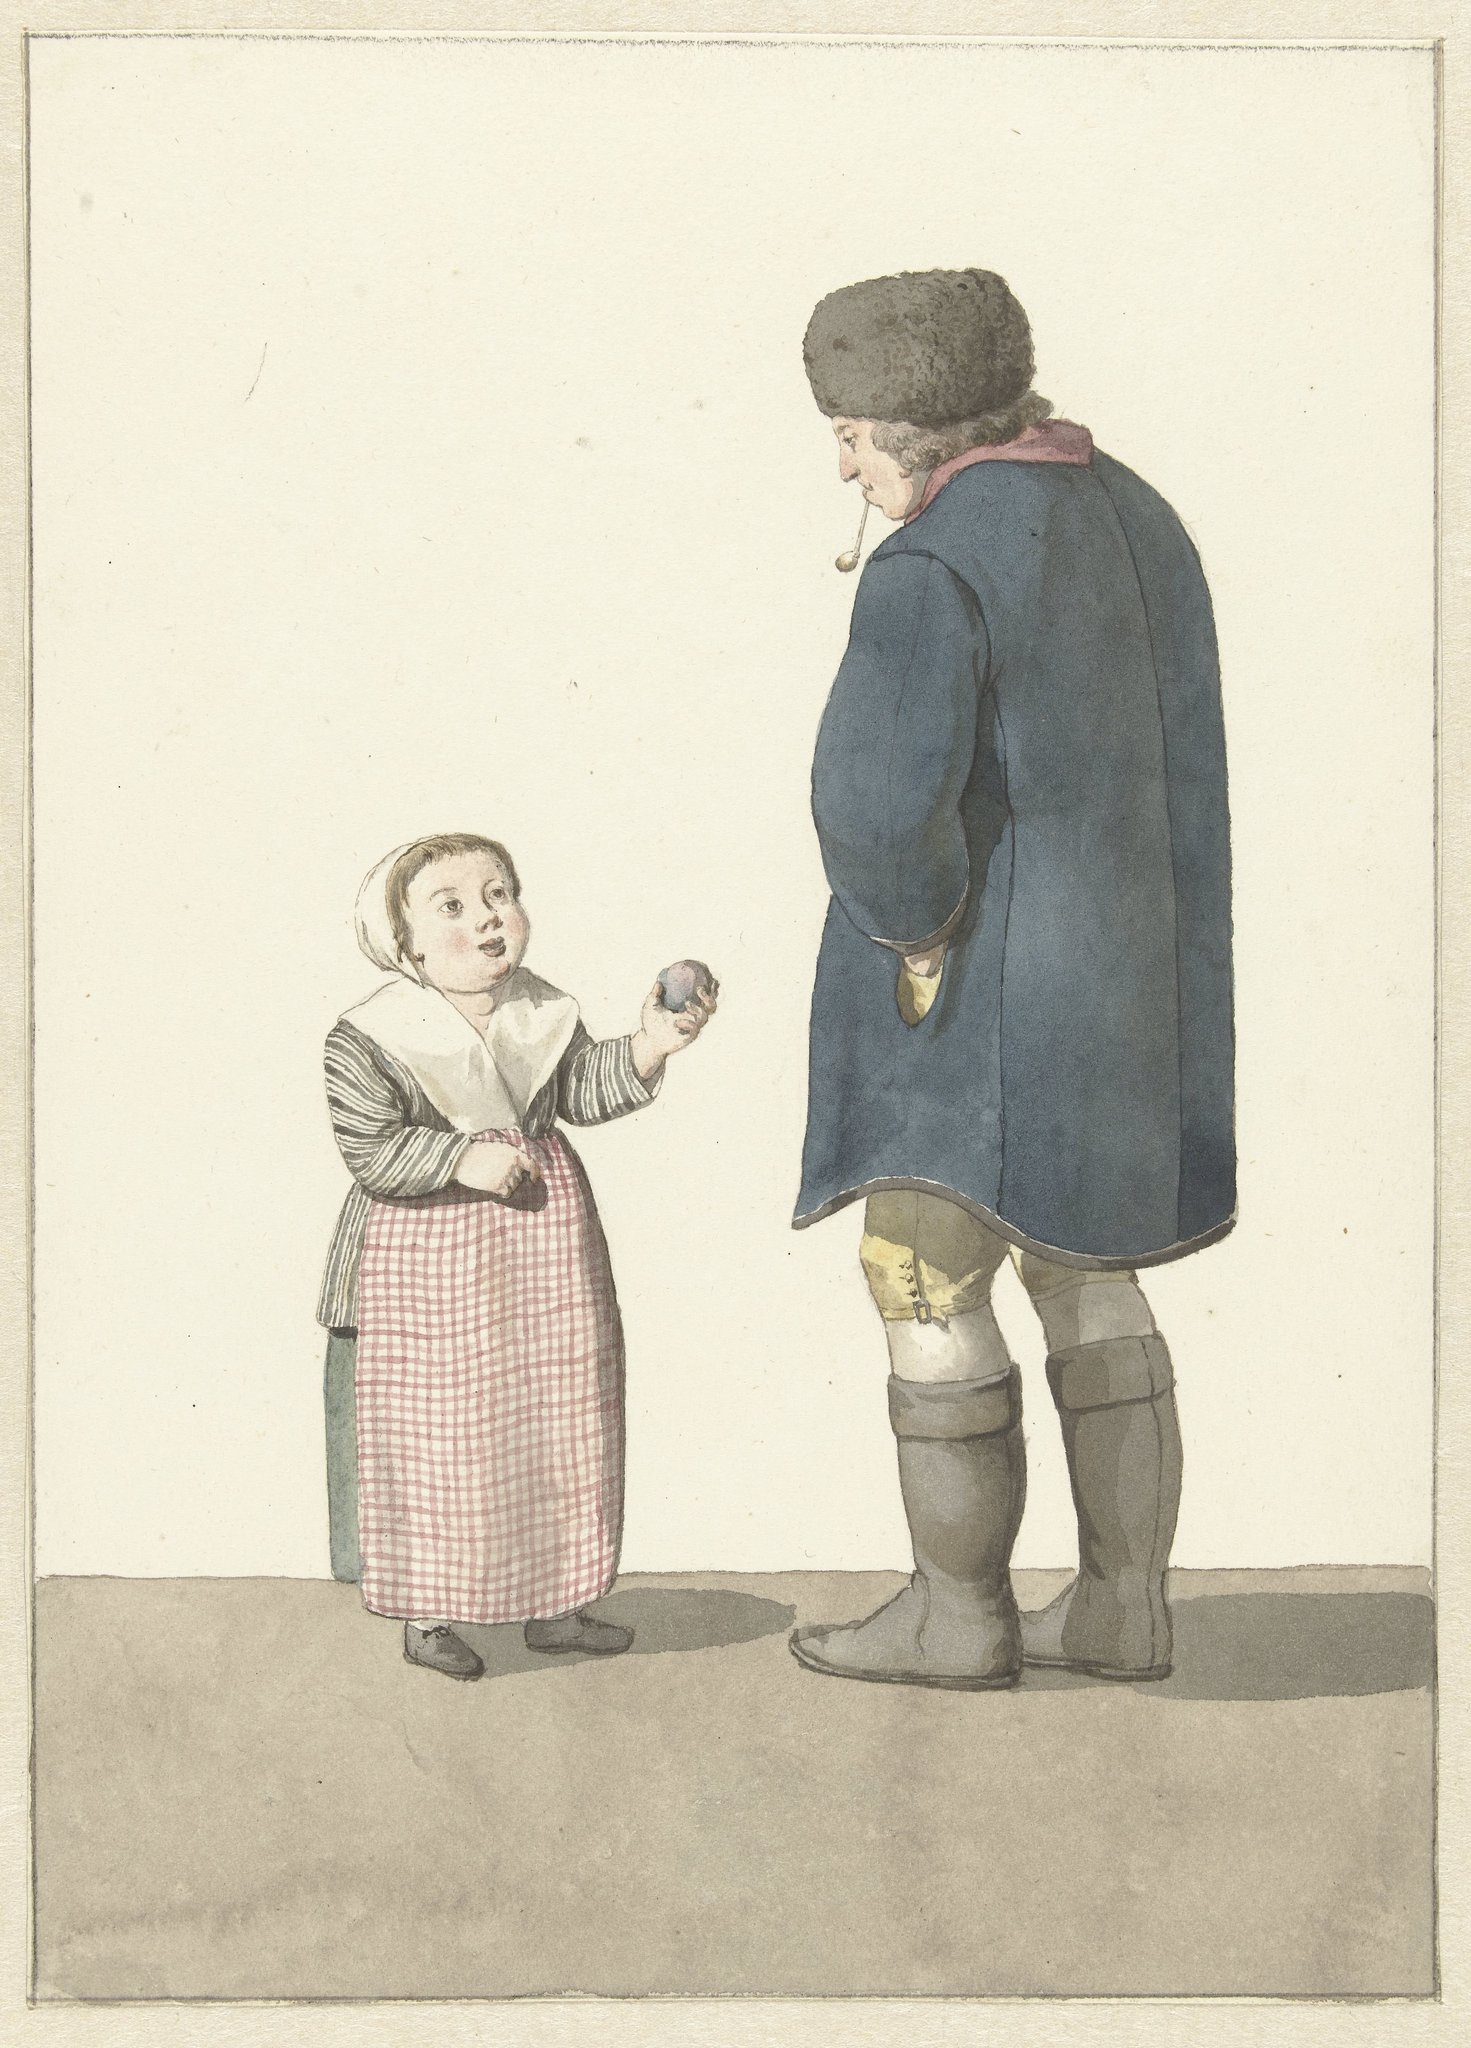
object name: watercolor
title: Meisje met bal staand voor een man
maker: w. barthautz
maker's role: draughtsman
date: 1700-1800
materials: ink, paper, watercolor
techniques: brush, pen